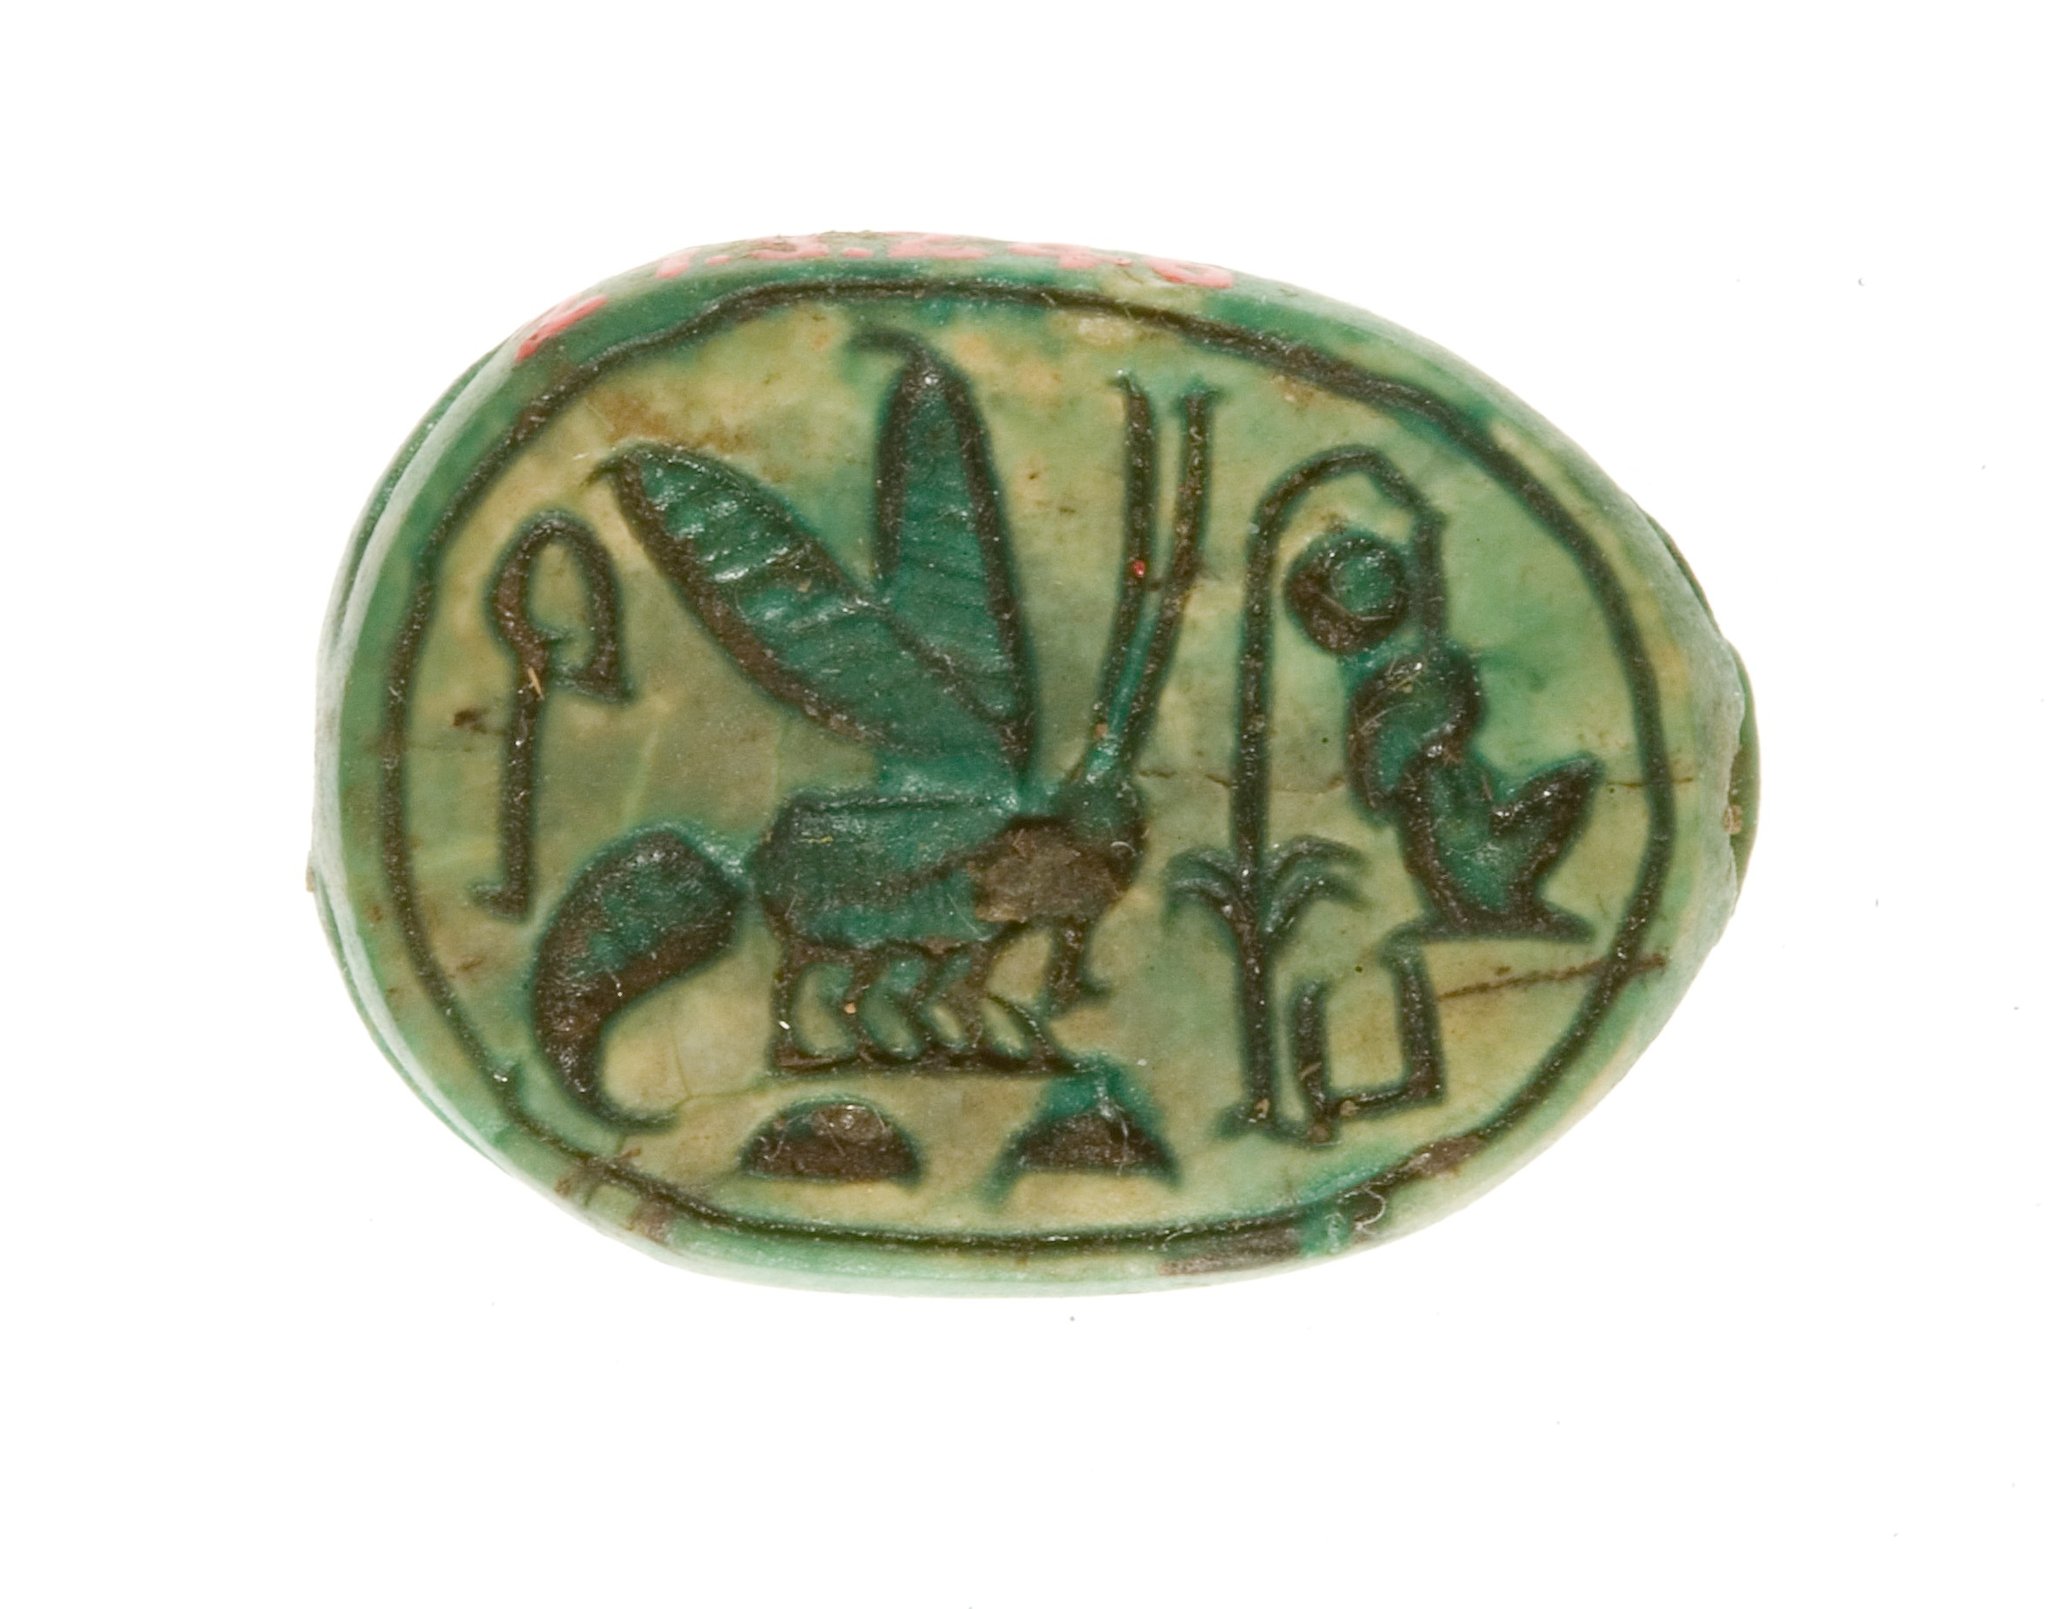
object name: scarab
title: Scarab Inscribed for the King of Upper and Lower Egypt, Maatkare (Hatshepsut)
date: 1479-1458 BCE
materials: stone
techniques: glazing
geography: egypt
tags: scarabs